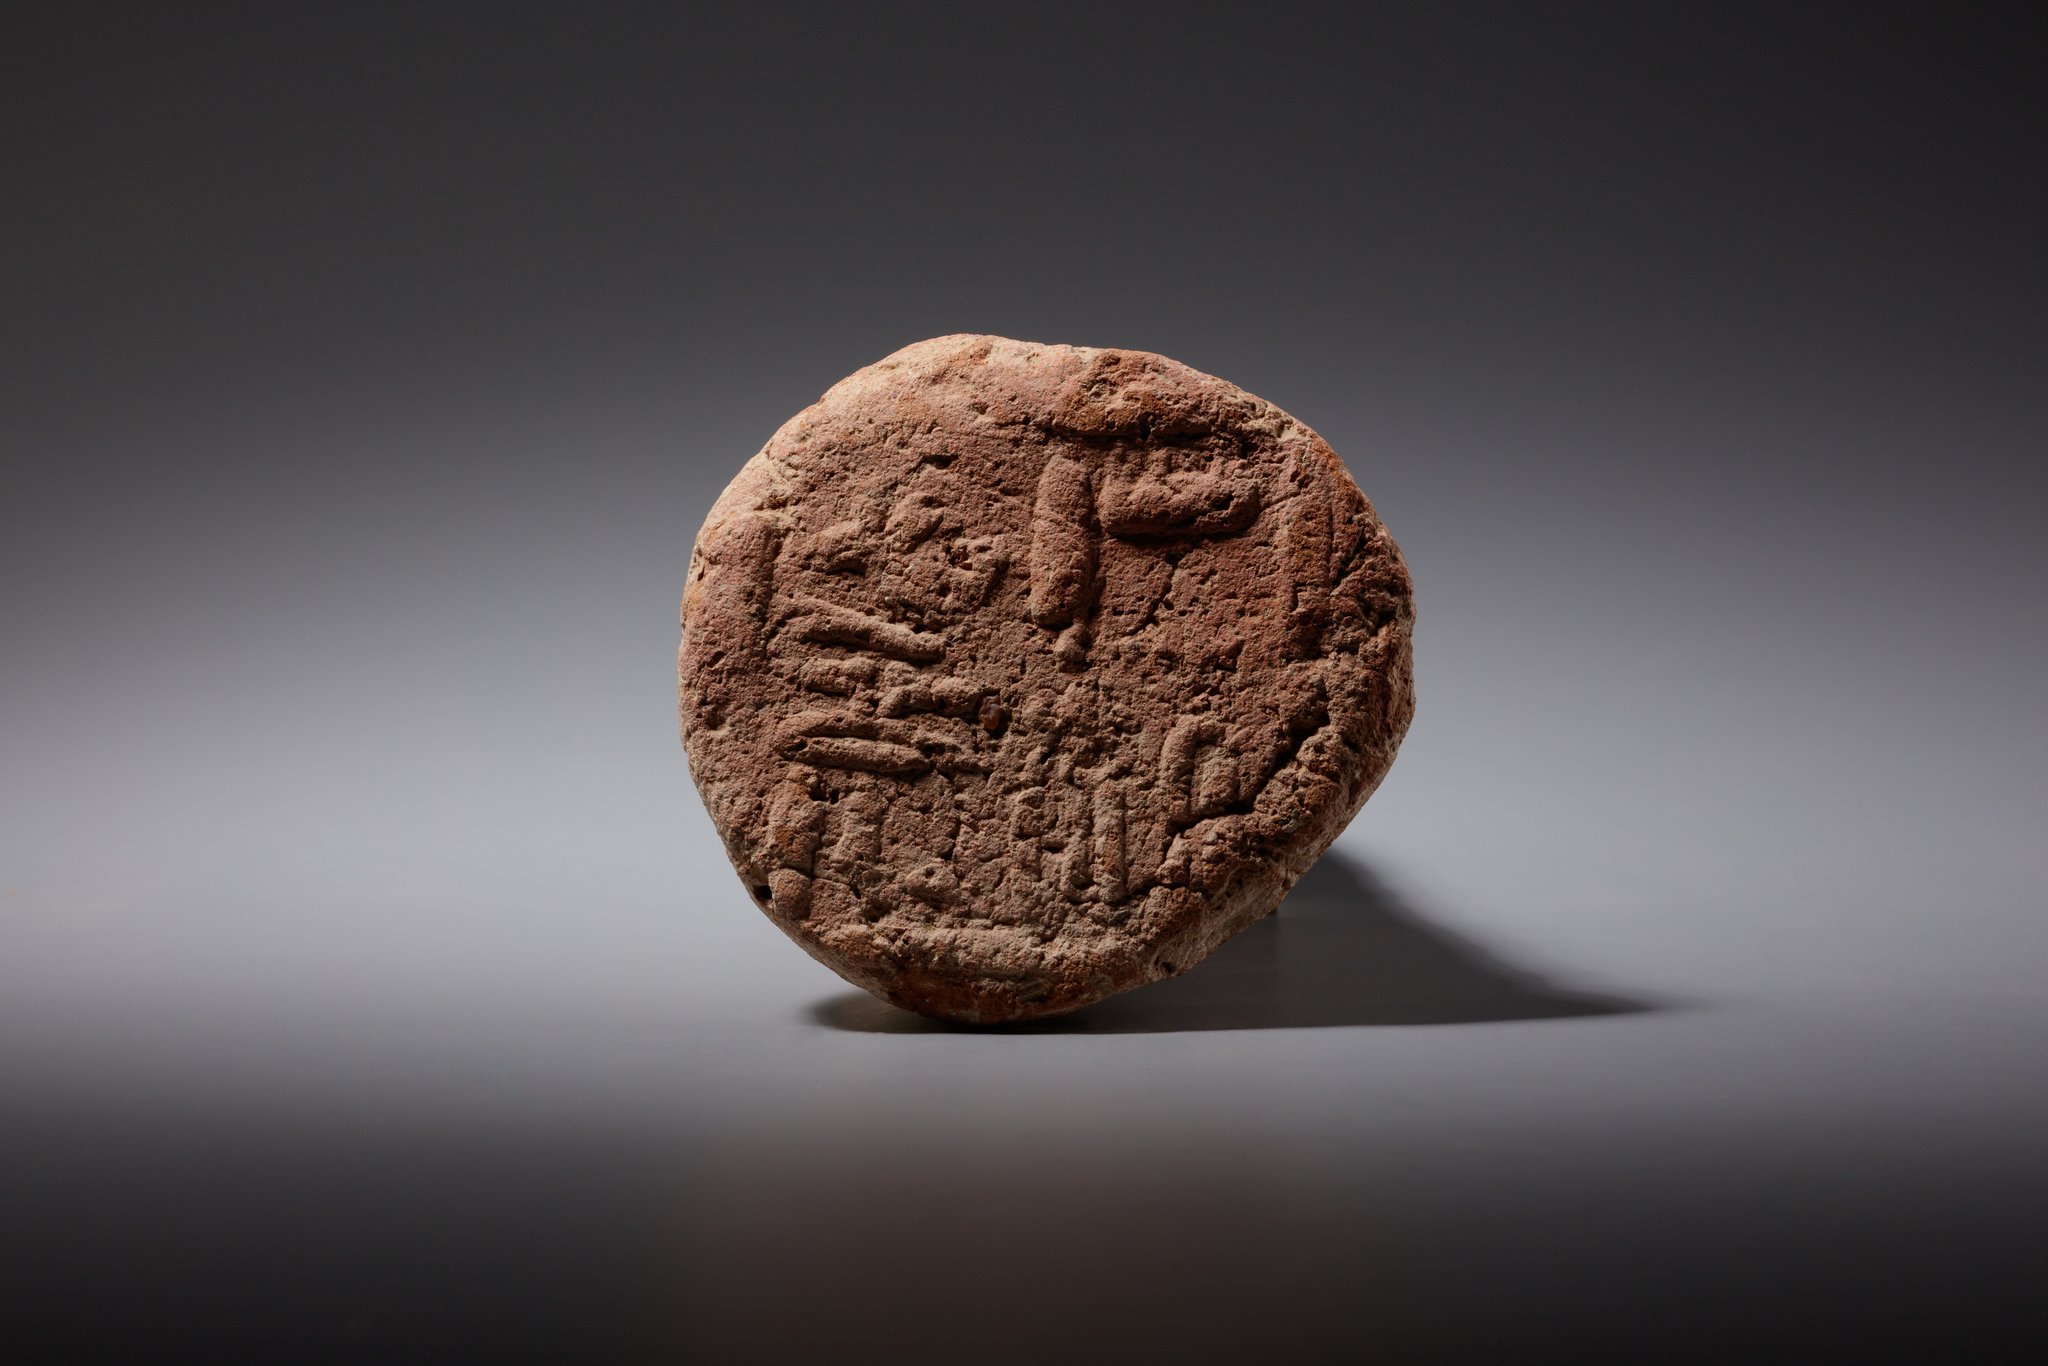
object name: cone, davy 325, amenmose, tt 118, standard bearer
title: Funerary Cone of the Standard-Bearer Amenmose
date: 1550-1295 BCE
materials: pottery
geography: egypt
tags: hieroglyphs